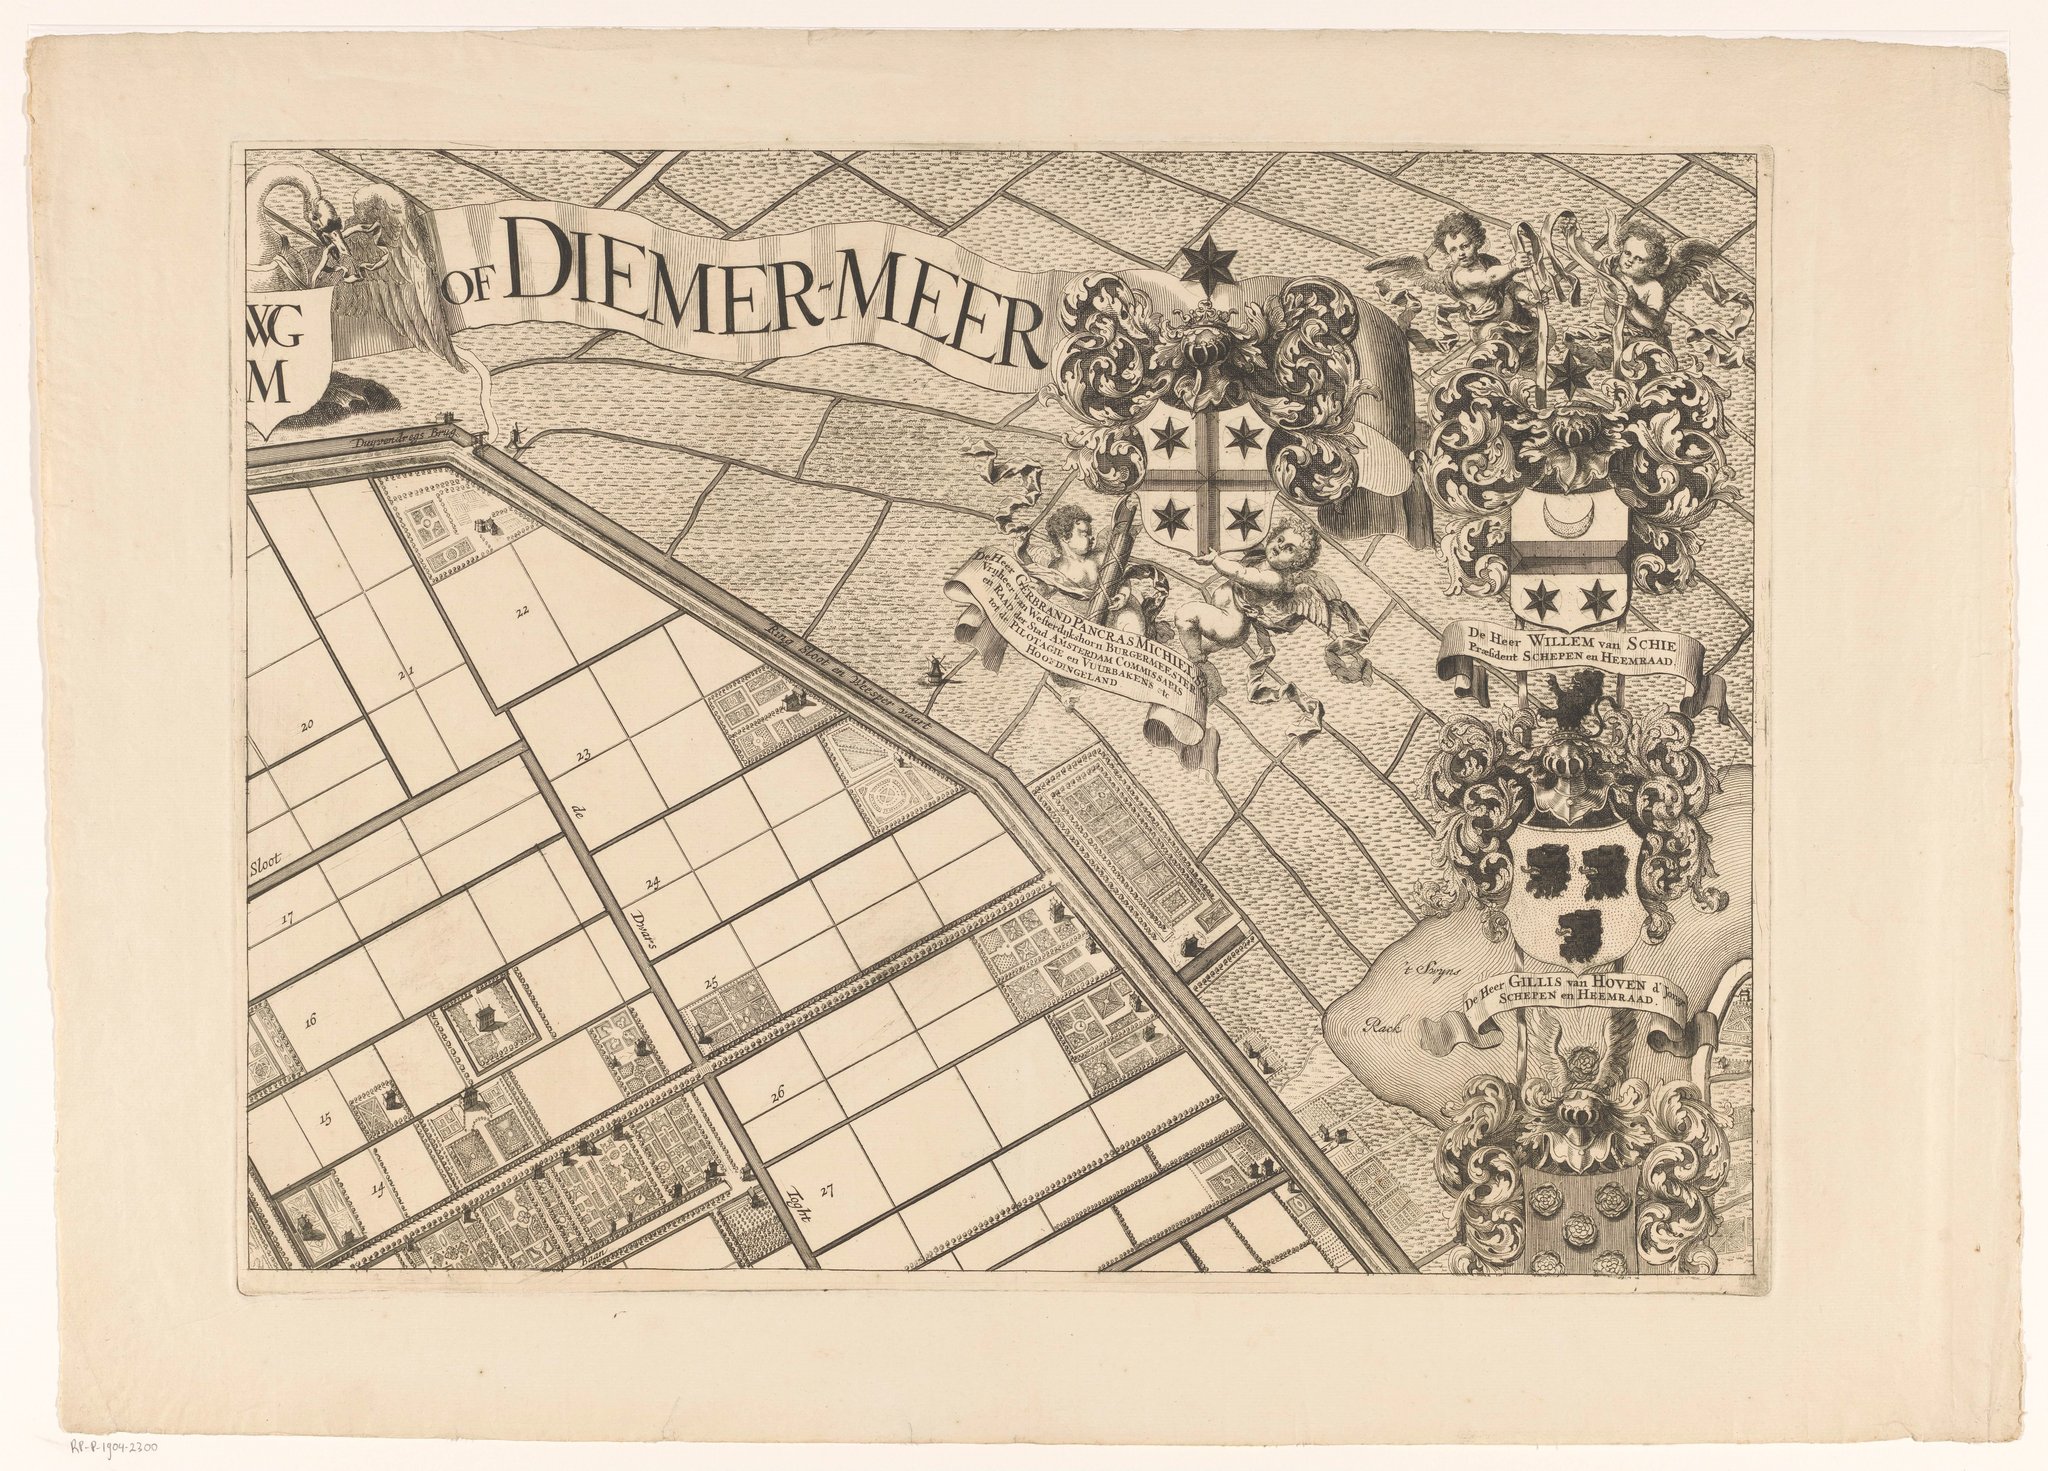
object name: map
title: Watergraafs of Diemer-meer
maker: pieter van den berge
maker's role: draughtsman, print maker, printer, publisher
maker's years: 1659-1737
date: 1719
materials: paper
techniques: engraving, etching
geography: amsterdam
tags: coat of arms (as symbol of the state, etc.), maps of separate countries or regions, polder, reclaimed land, armorial bearing, heraldry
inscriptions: collector's mark: Lugt 2228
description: Deel (rechtsboven) van een kaart van de Watergraafsmeer.